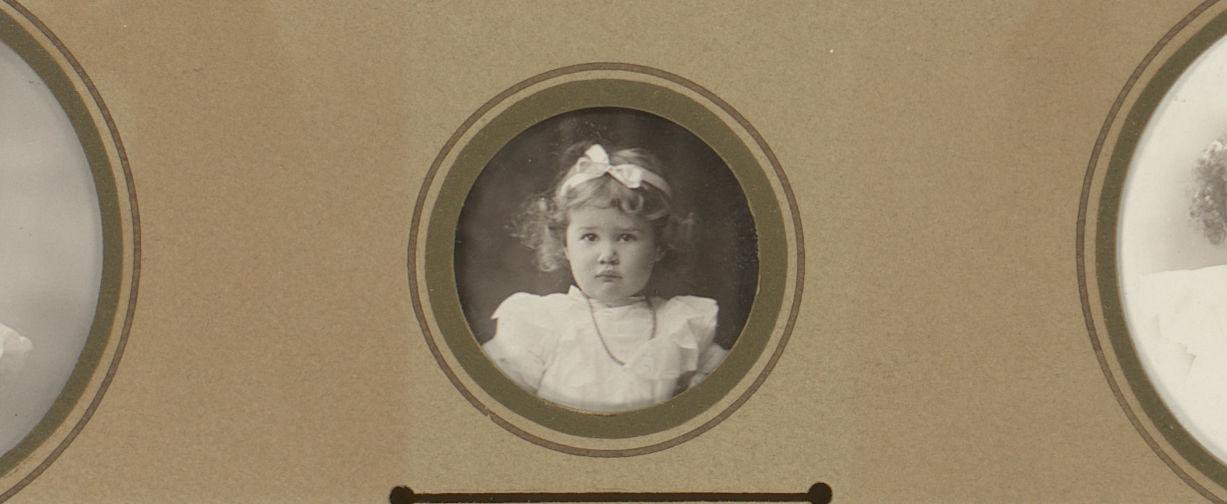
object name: photograph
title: Portret van een jong meisje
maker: Anonymous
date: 1895-1920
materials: cardboard, photographic support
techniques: matte daylight collodion silver print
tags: historical persons - bb - woman, toddler (female)